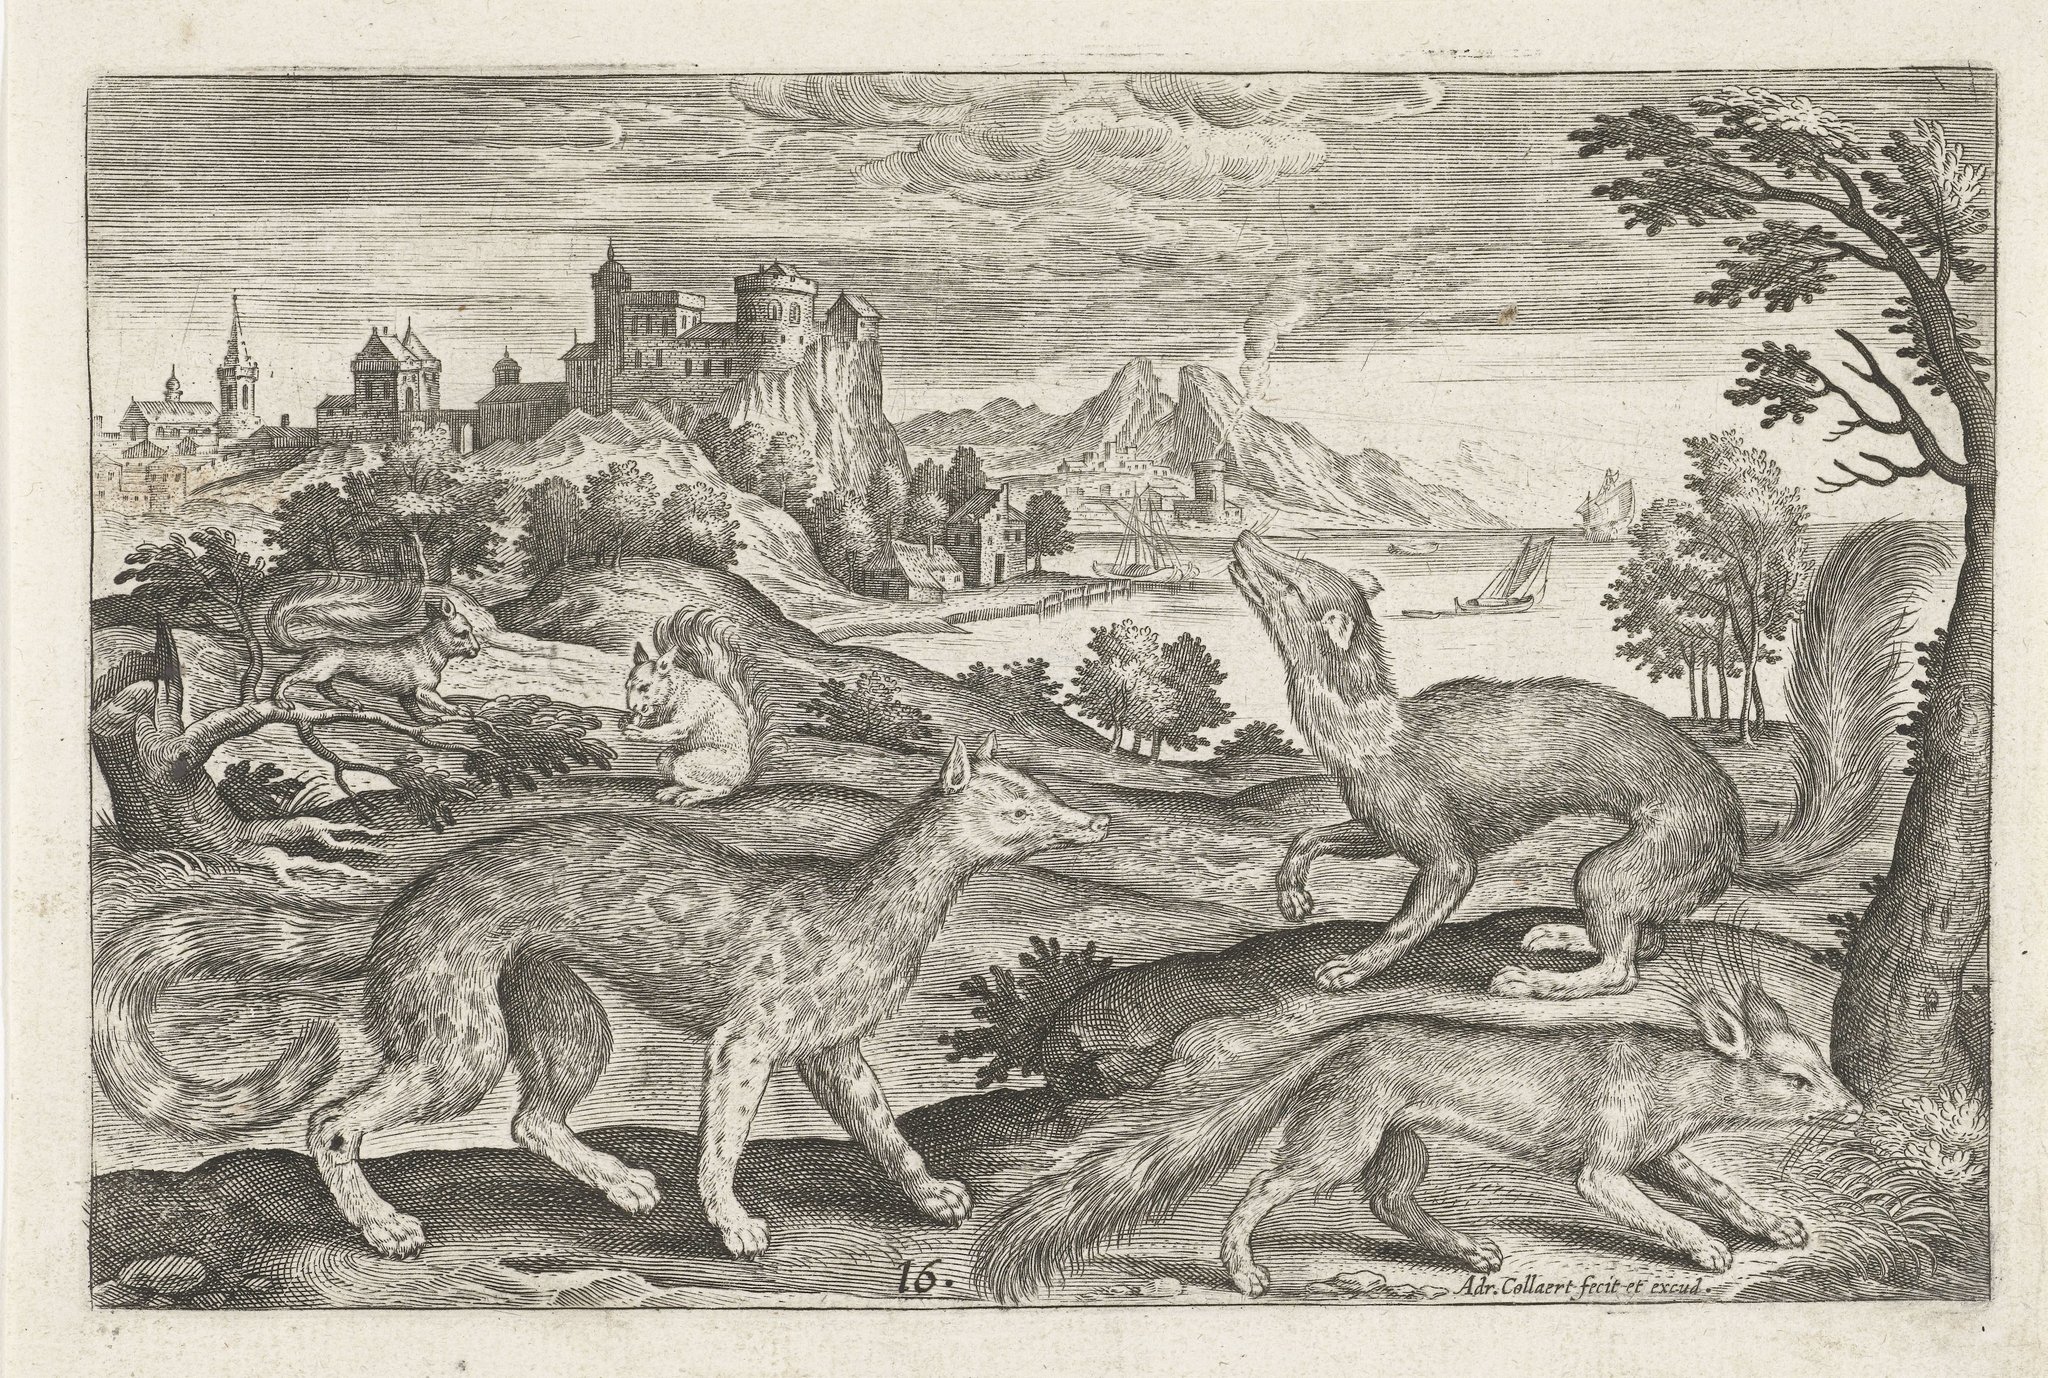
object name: print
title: Vierpotige dieren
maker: adriaen collaert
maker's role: draughtsman, print maker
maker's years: 1560-1618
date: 1595-1599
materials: paper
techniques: engraving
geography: antwerp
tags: landscapes, beasts of prey, predatory animals: polecat, rodents: squirrel, beasts of prey, predatory animals: marten, beasts of prey, predatory animals: fox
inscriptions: collector's mark: Lugt 2228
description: Op de voorgrond een vos, een marter en een gevlekte bunzing. Op de achtergrond een twee eekhoorn in een landschap. De prent maakt deel uit van een serie met als onderwerp dieren.